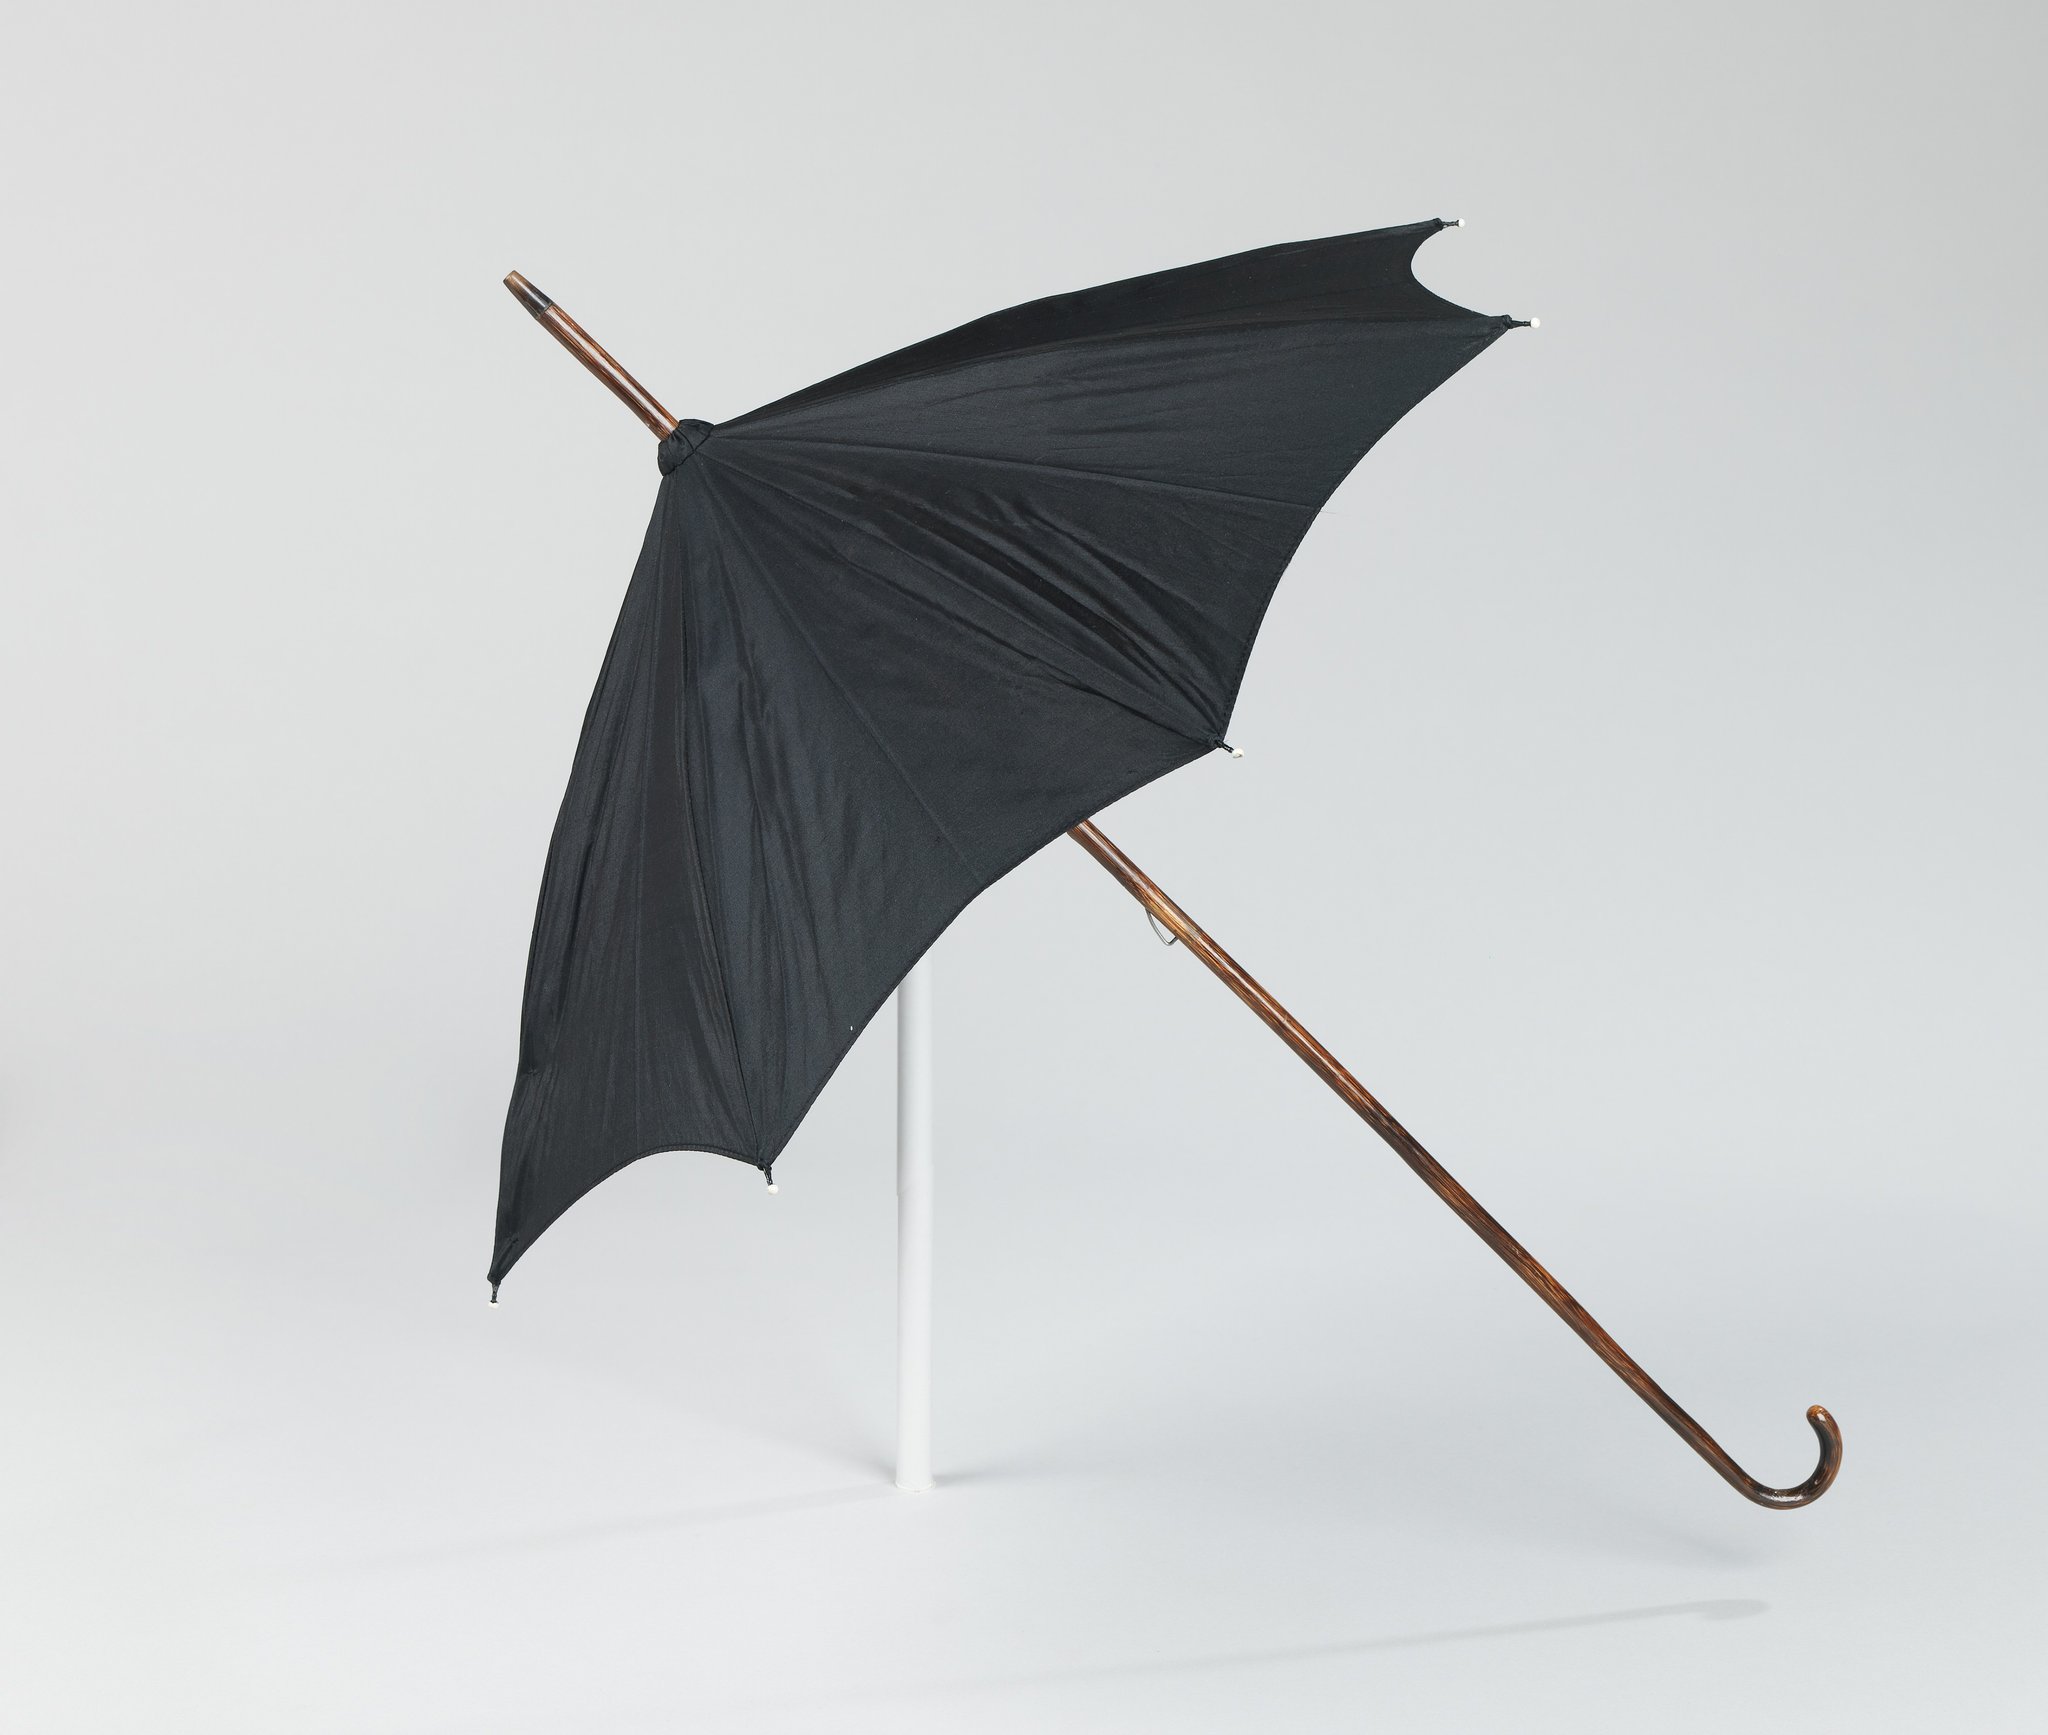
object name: parasol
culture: american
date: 1850-1859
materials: metal, silk, wood